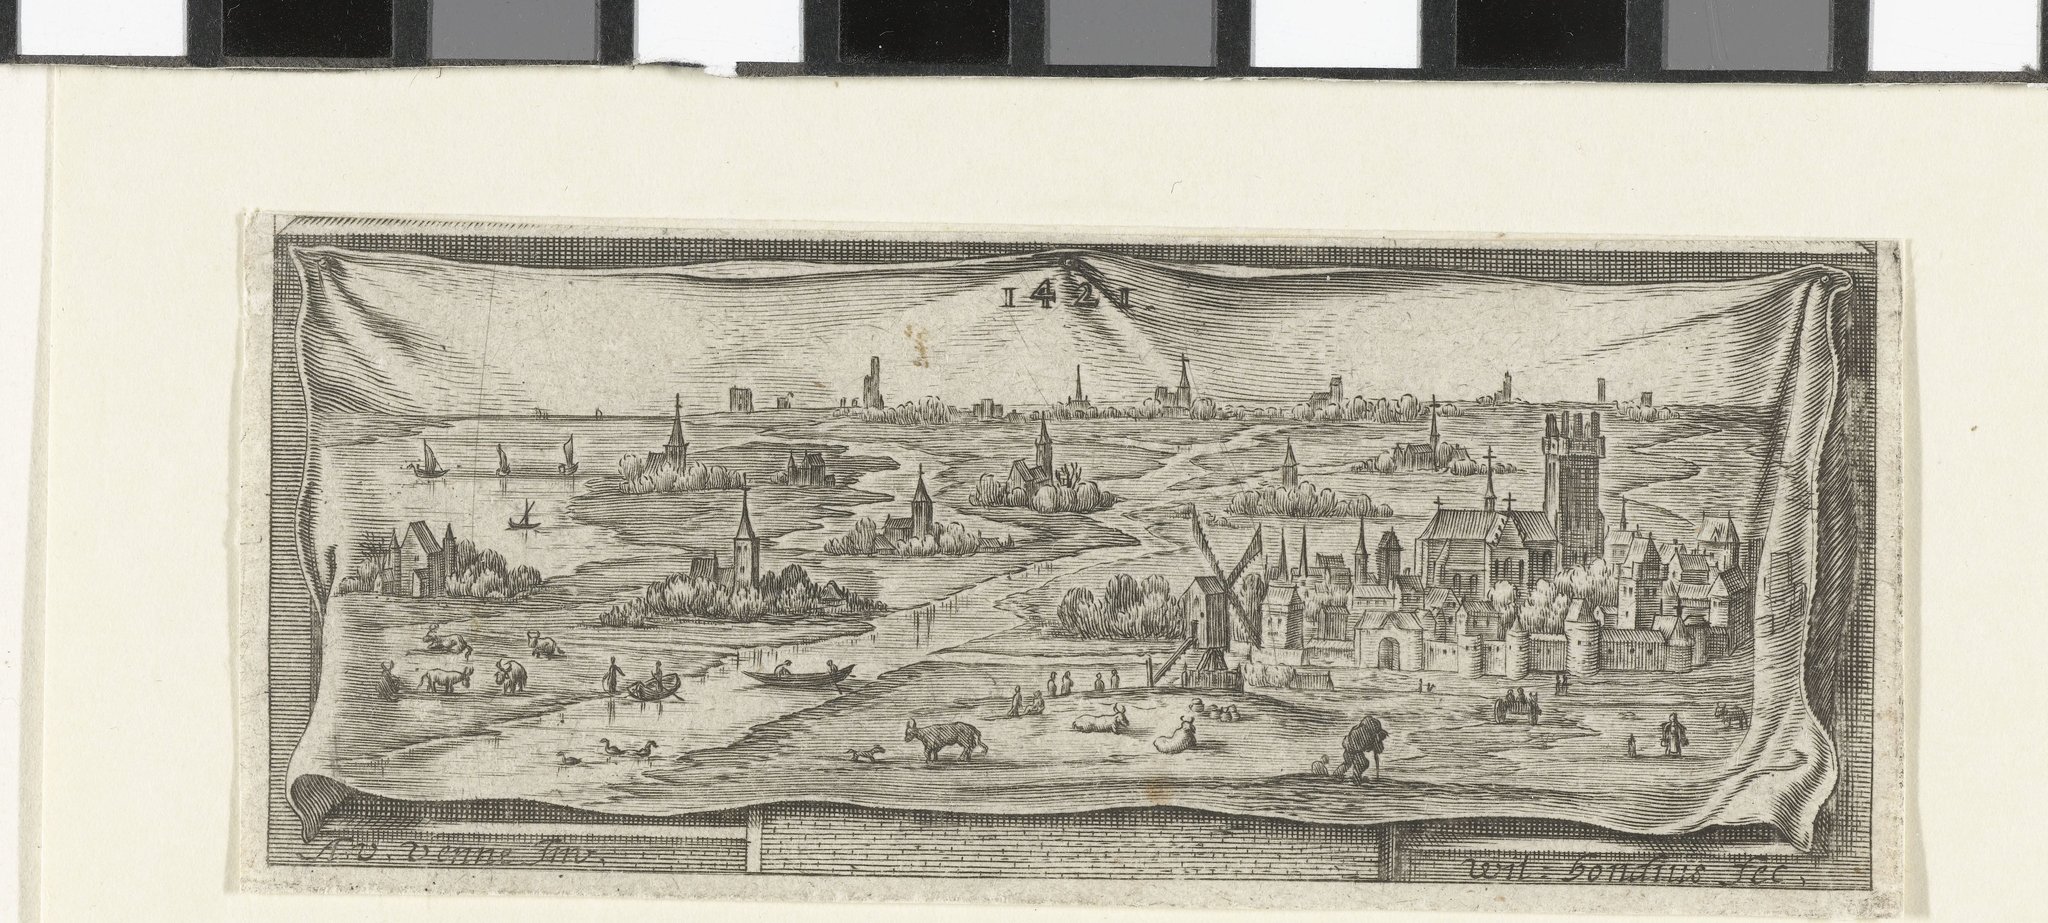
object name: print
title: Dordrecht na de Sint Elisabethsvloed, 1421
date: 1626-1628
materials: paper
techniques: engraving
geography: northern netherlands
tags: flood, dordrecht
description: Gebruikt - in een latere staat - als deel van een frontispice voor: Jacob van der Eyck, Corte Beschrijvinghe mitsgaders Hantvesten, Privilegien, Costvmen ende Ordonnantien vanden Lande van Zuyt-Hollandt. Dordrecht 1628. In de latere staat met centraal onderaan de vermelding van de privilege voor XIV jaar van de uitgever / drukker Nicolaes Vincentsz. van Spierincxhouck.